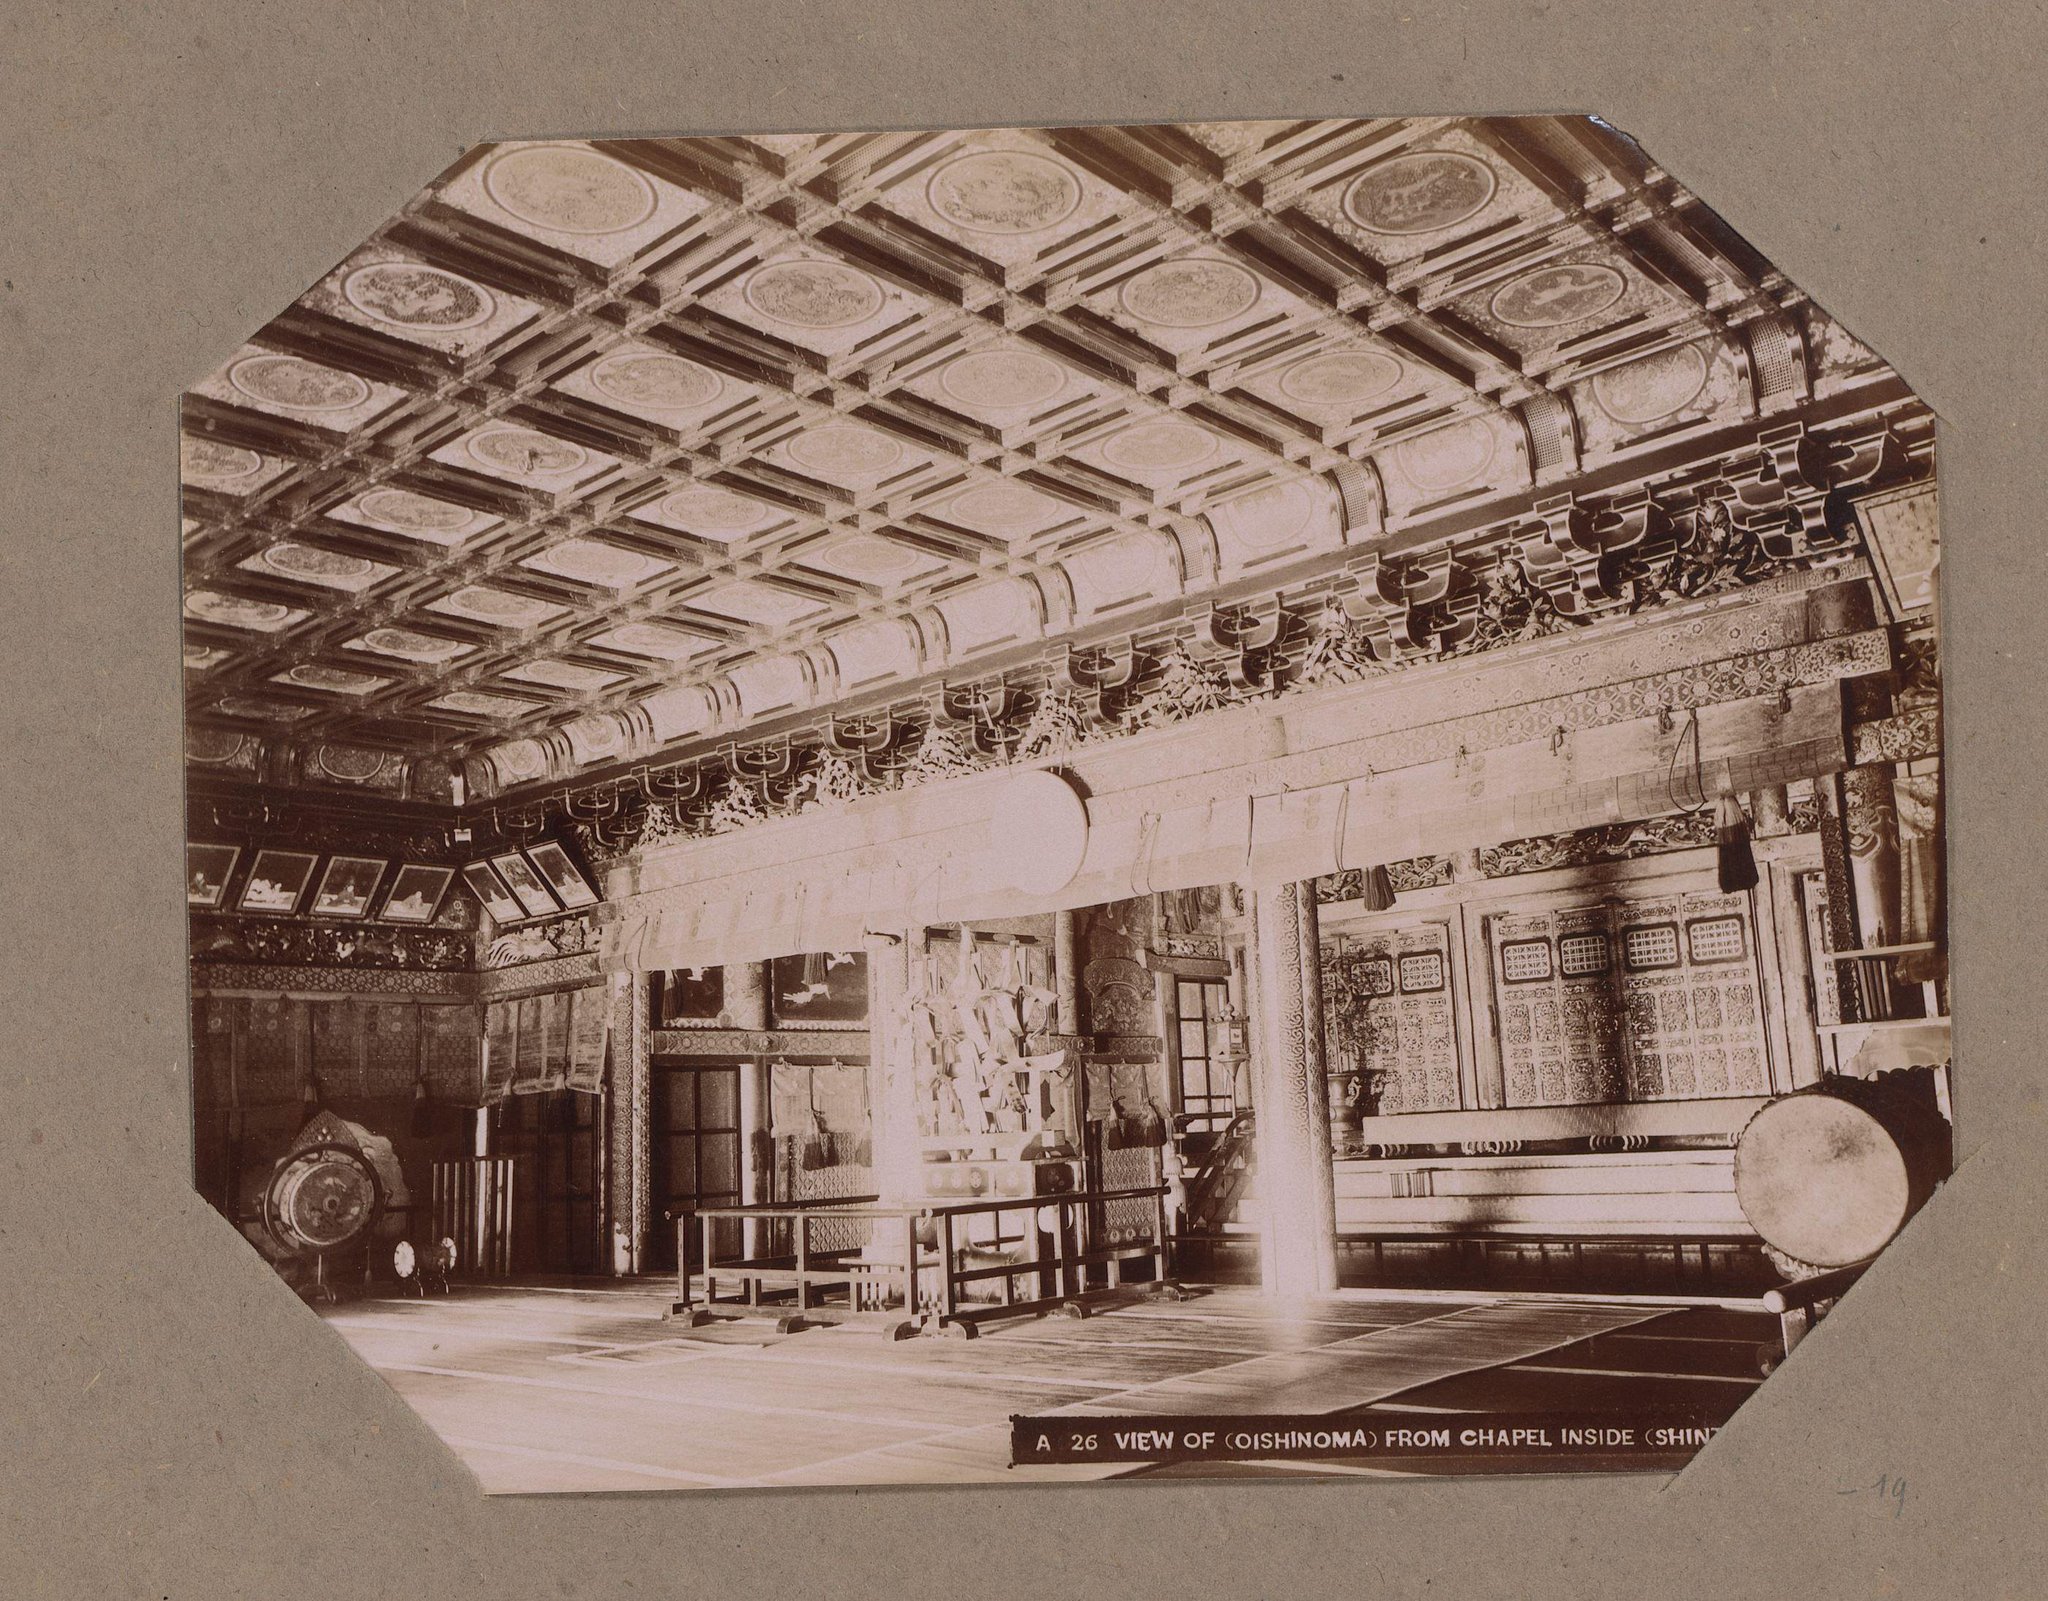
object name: album leaf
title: Interieur van een gebedsruimte in één van de Shinto tempels in Nikko, Japan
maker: Anonymous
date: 1890-1903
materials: paper, photographic support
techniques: albumen print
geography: nikko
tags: temple, shrine ~ shinto, ritual practices ~ shinto, interior of the house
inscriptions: inscription: ‘A 26 View of (Oishinoma) from Chapel inside (Shinto) Temple Nikko.’